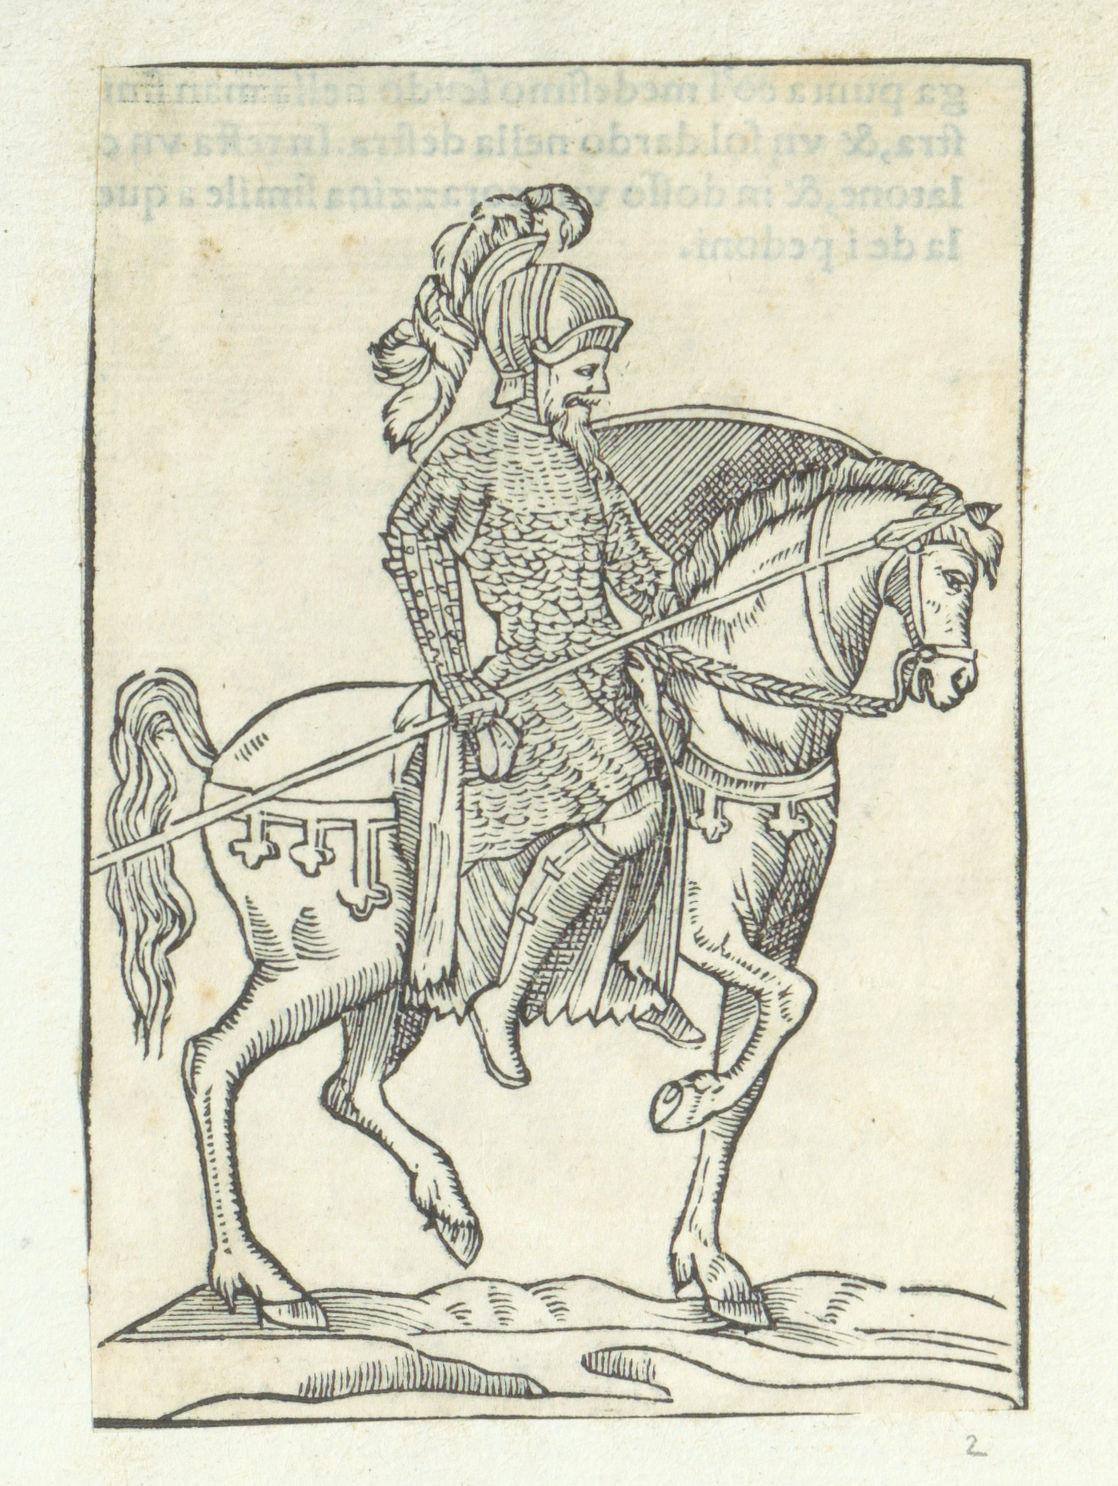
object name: print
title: Ruiter met lans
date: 1558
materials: paper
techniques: engraving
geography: italy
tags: riding a horse, ass, or mule; rider, horseman, armour, casting weapons: spear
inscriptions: inscription: ‘[...] ende lib. vol. 10 fol. 5 [...] vol. 6.’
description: Illustratie voor de publicatie: Olmo, Innocenzo. Discorso del S. Guglielmo Choul gentilhuomo lionese... Innocenzo Olmo, 1558.